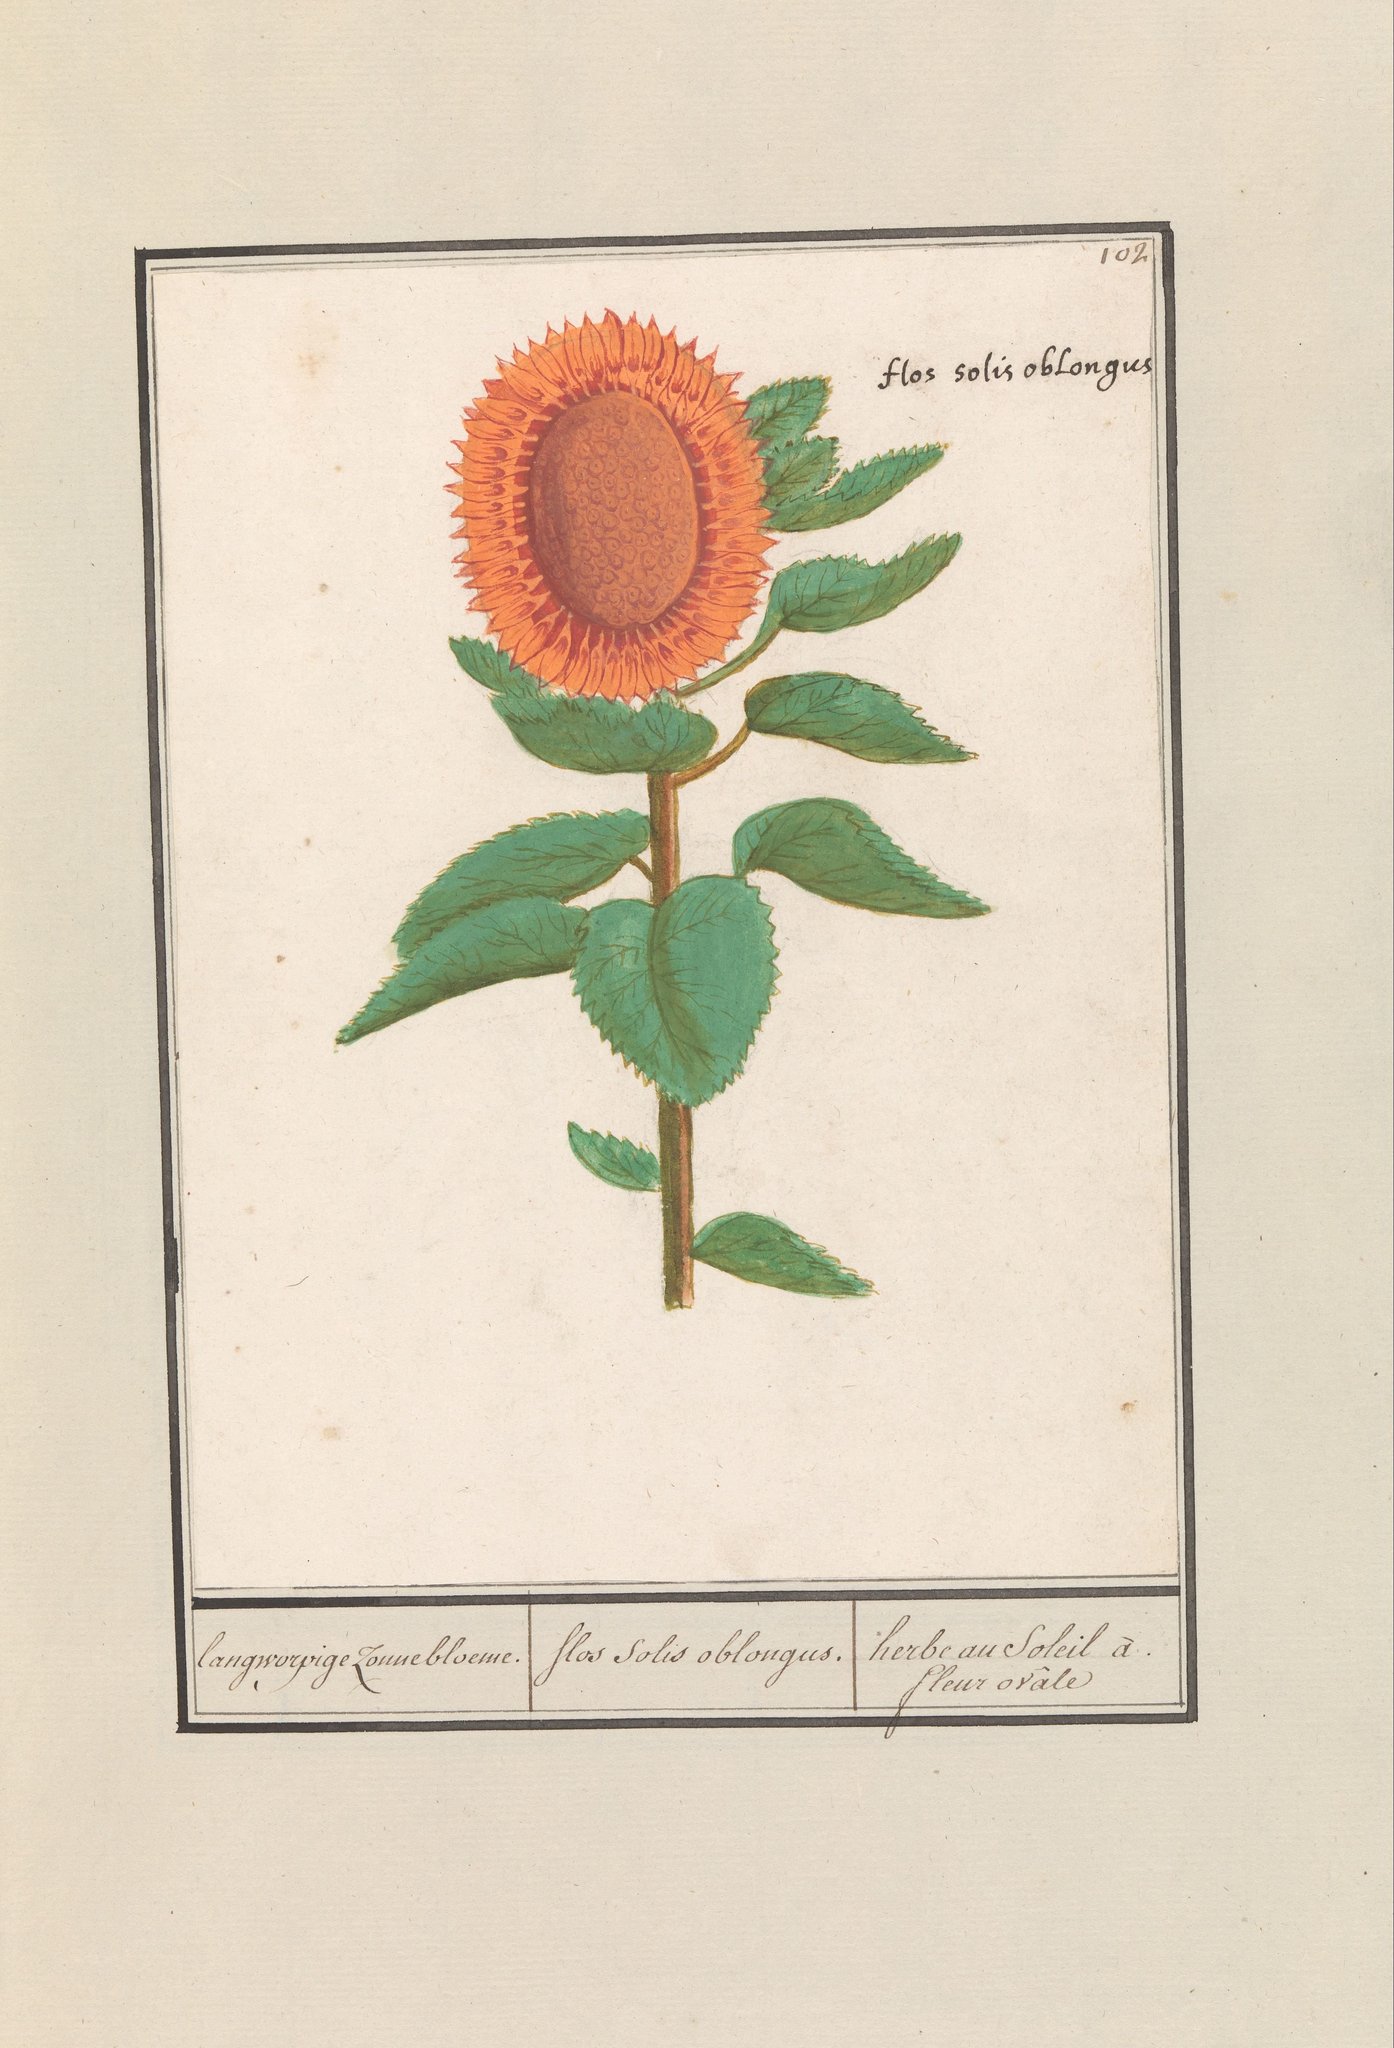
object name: drawing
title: langworpige Zonnebloeme. / flos solis oblongus. / herbe au Soleil à. fleur ovâle.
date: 1596-1610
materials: chalk, paint, ink, paper, watercolor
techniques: brush, pen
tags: flowers: sunflower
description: Zonnebloem met een ovale bloem. Rechtsboven genummerd: 102. Met de Latijnse naam. Onderdeel van het tweede album met tekeningen van bloemen en planten. Negende van twaalf albums met tekeningen van dieren, vogels en planten bekend rond 1600, gemaakt in opdracht van keizer Rudolf II. Met toelichting in Nederlands, Latijn en Frans.